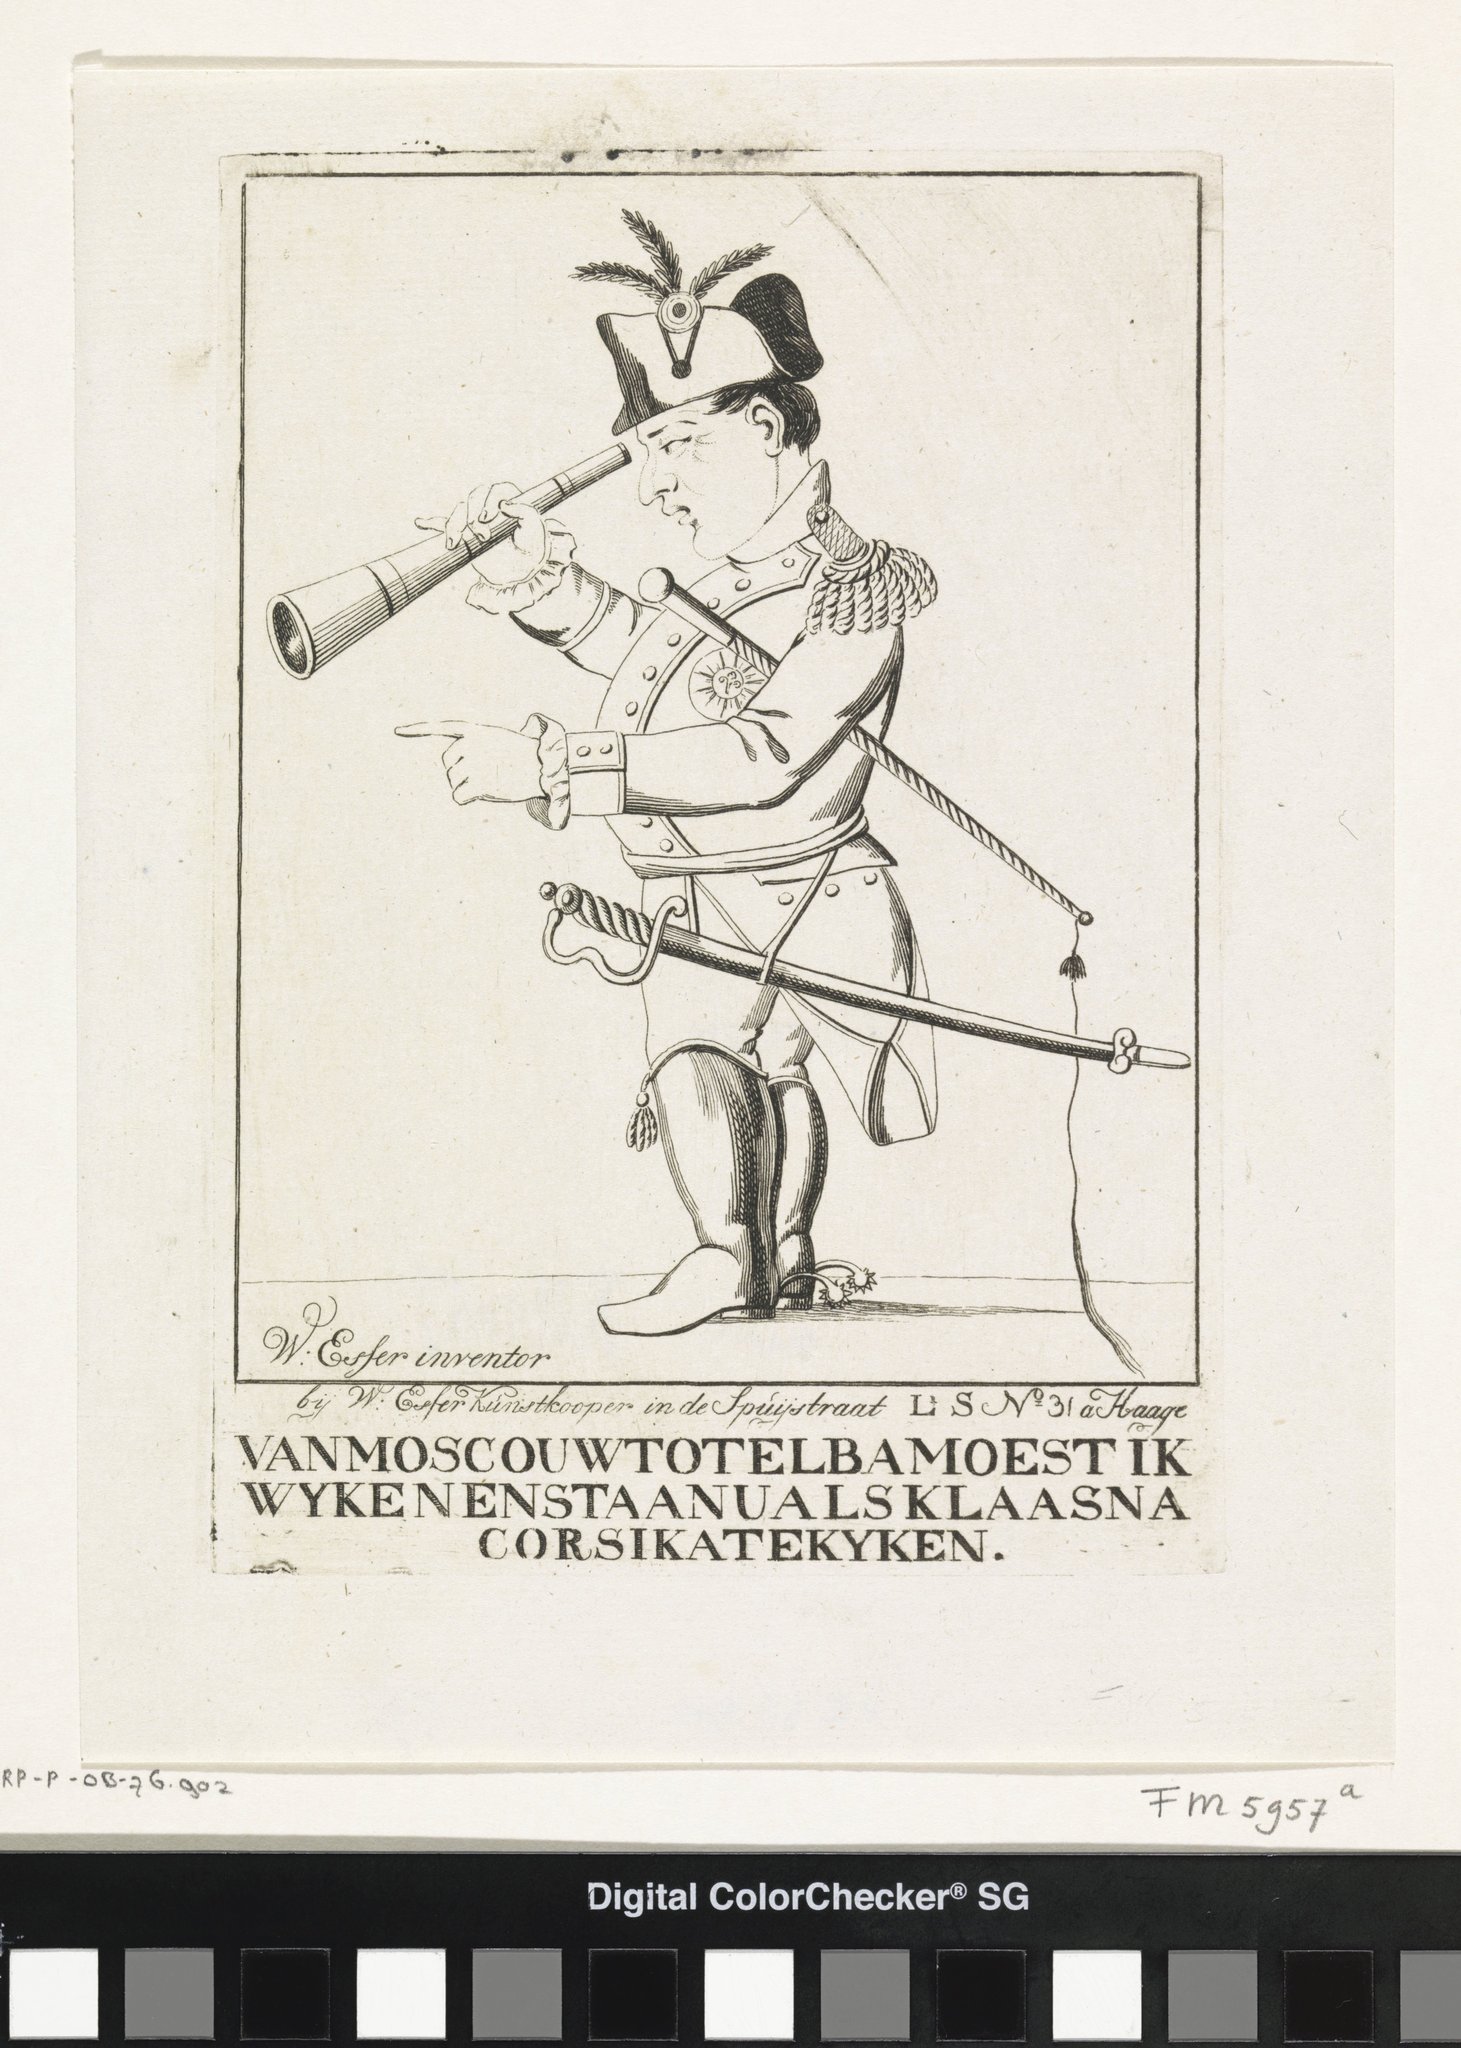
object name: cartoon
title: Spotprent op Napoleons verbanning naar Elba, 1814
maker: wijnand esser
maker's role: draughtsman, print maker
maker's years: 1779-1860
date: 1814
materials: paper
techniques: engraving, etching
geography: the hague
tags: napoleon i (emperor of the french), telescope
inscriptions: collector's mark: Lugt 2228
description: Spotprent op Napoleons verbanning naar Elba, mei 1814. Napoleon staande in profiel naar links, kijkend door een verrekijker.